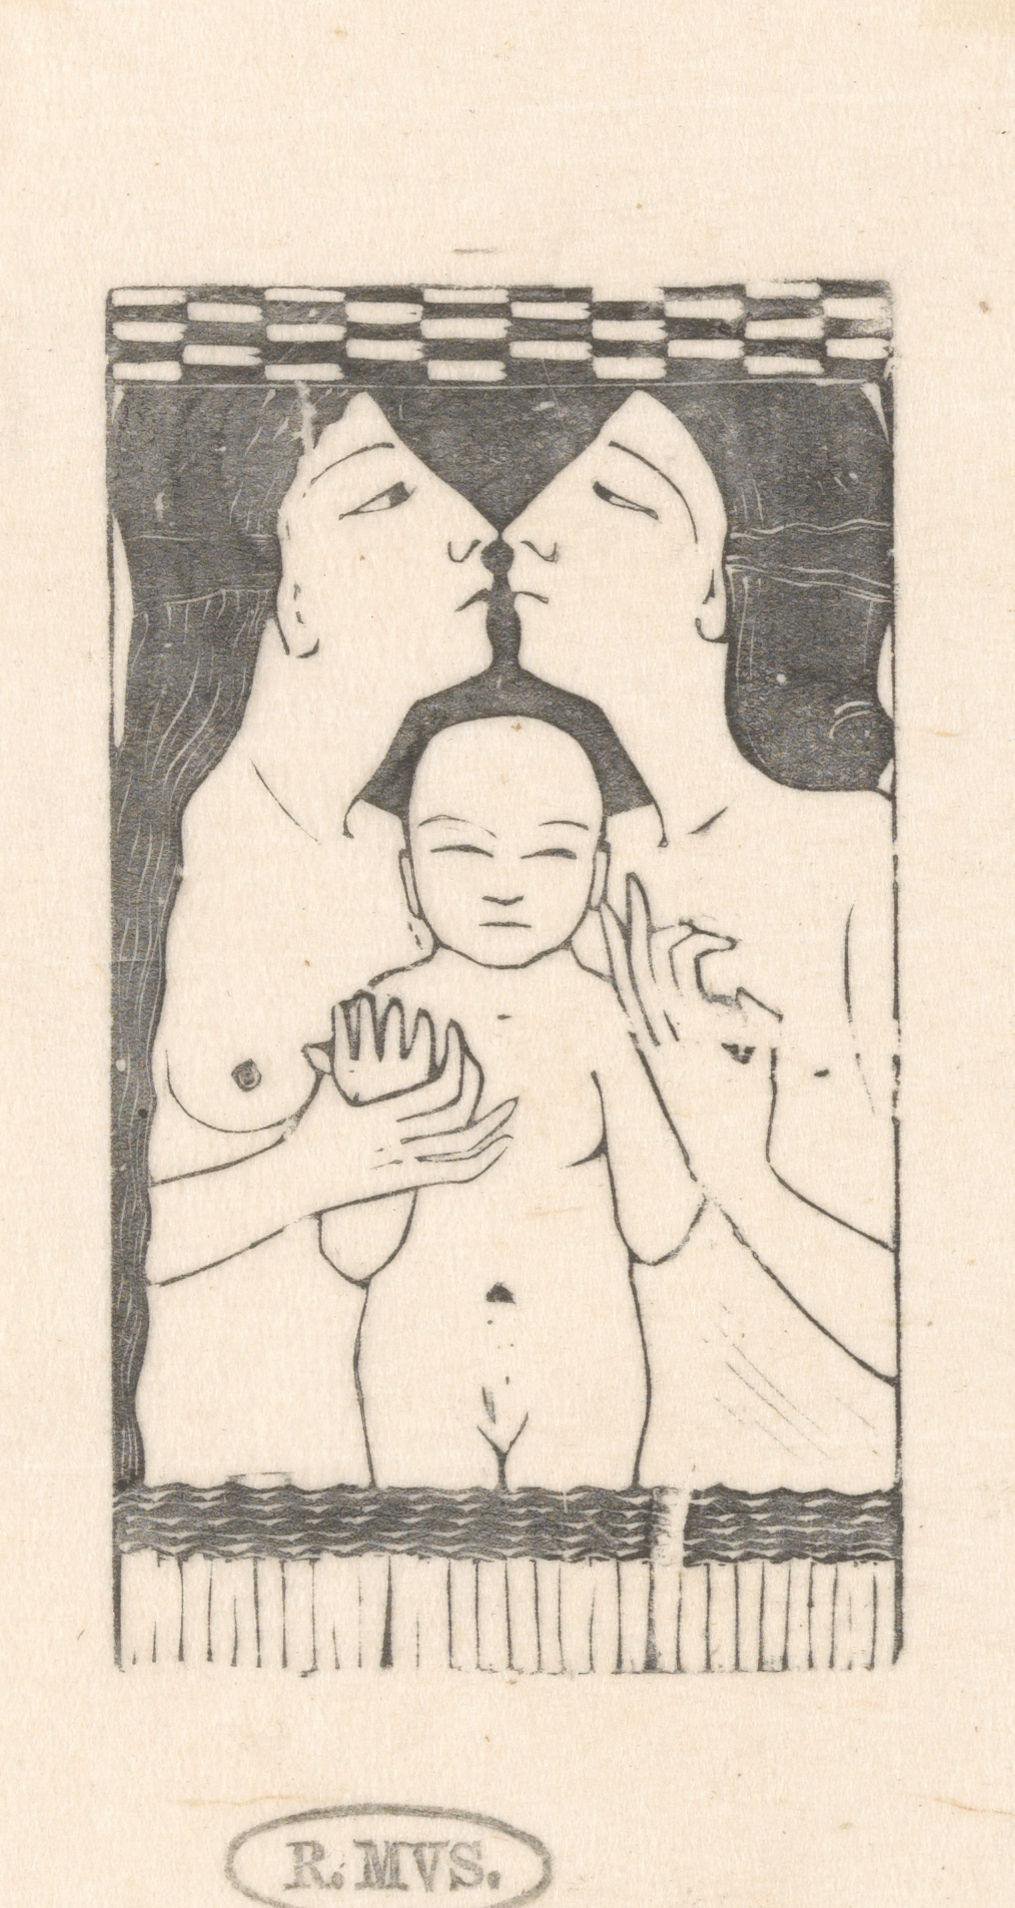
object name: illustration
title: Man, vrouw en kind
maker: karel petrus cornelis de bazel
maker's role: draughtsman, print maker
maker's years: 1869-1923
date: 1895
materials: paper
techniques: woodcut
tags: (showing oneself) undressed, quasi-nude, family, relationship, descent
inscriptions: collector's mark: Lugt 2228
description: Als illustratie verschenen in het tijdschrift 'Licht en Waarheid' V, nr. 130 (20 april 1895).